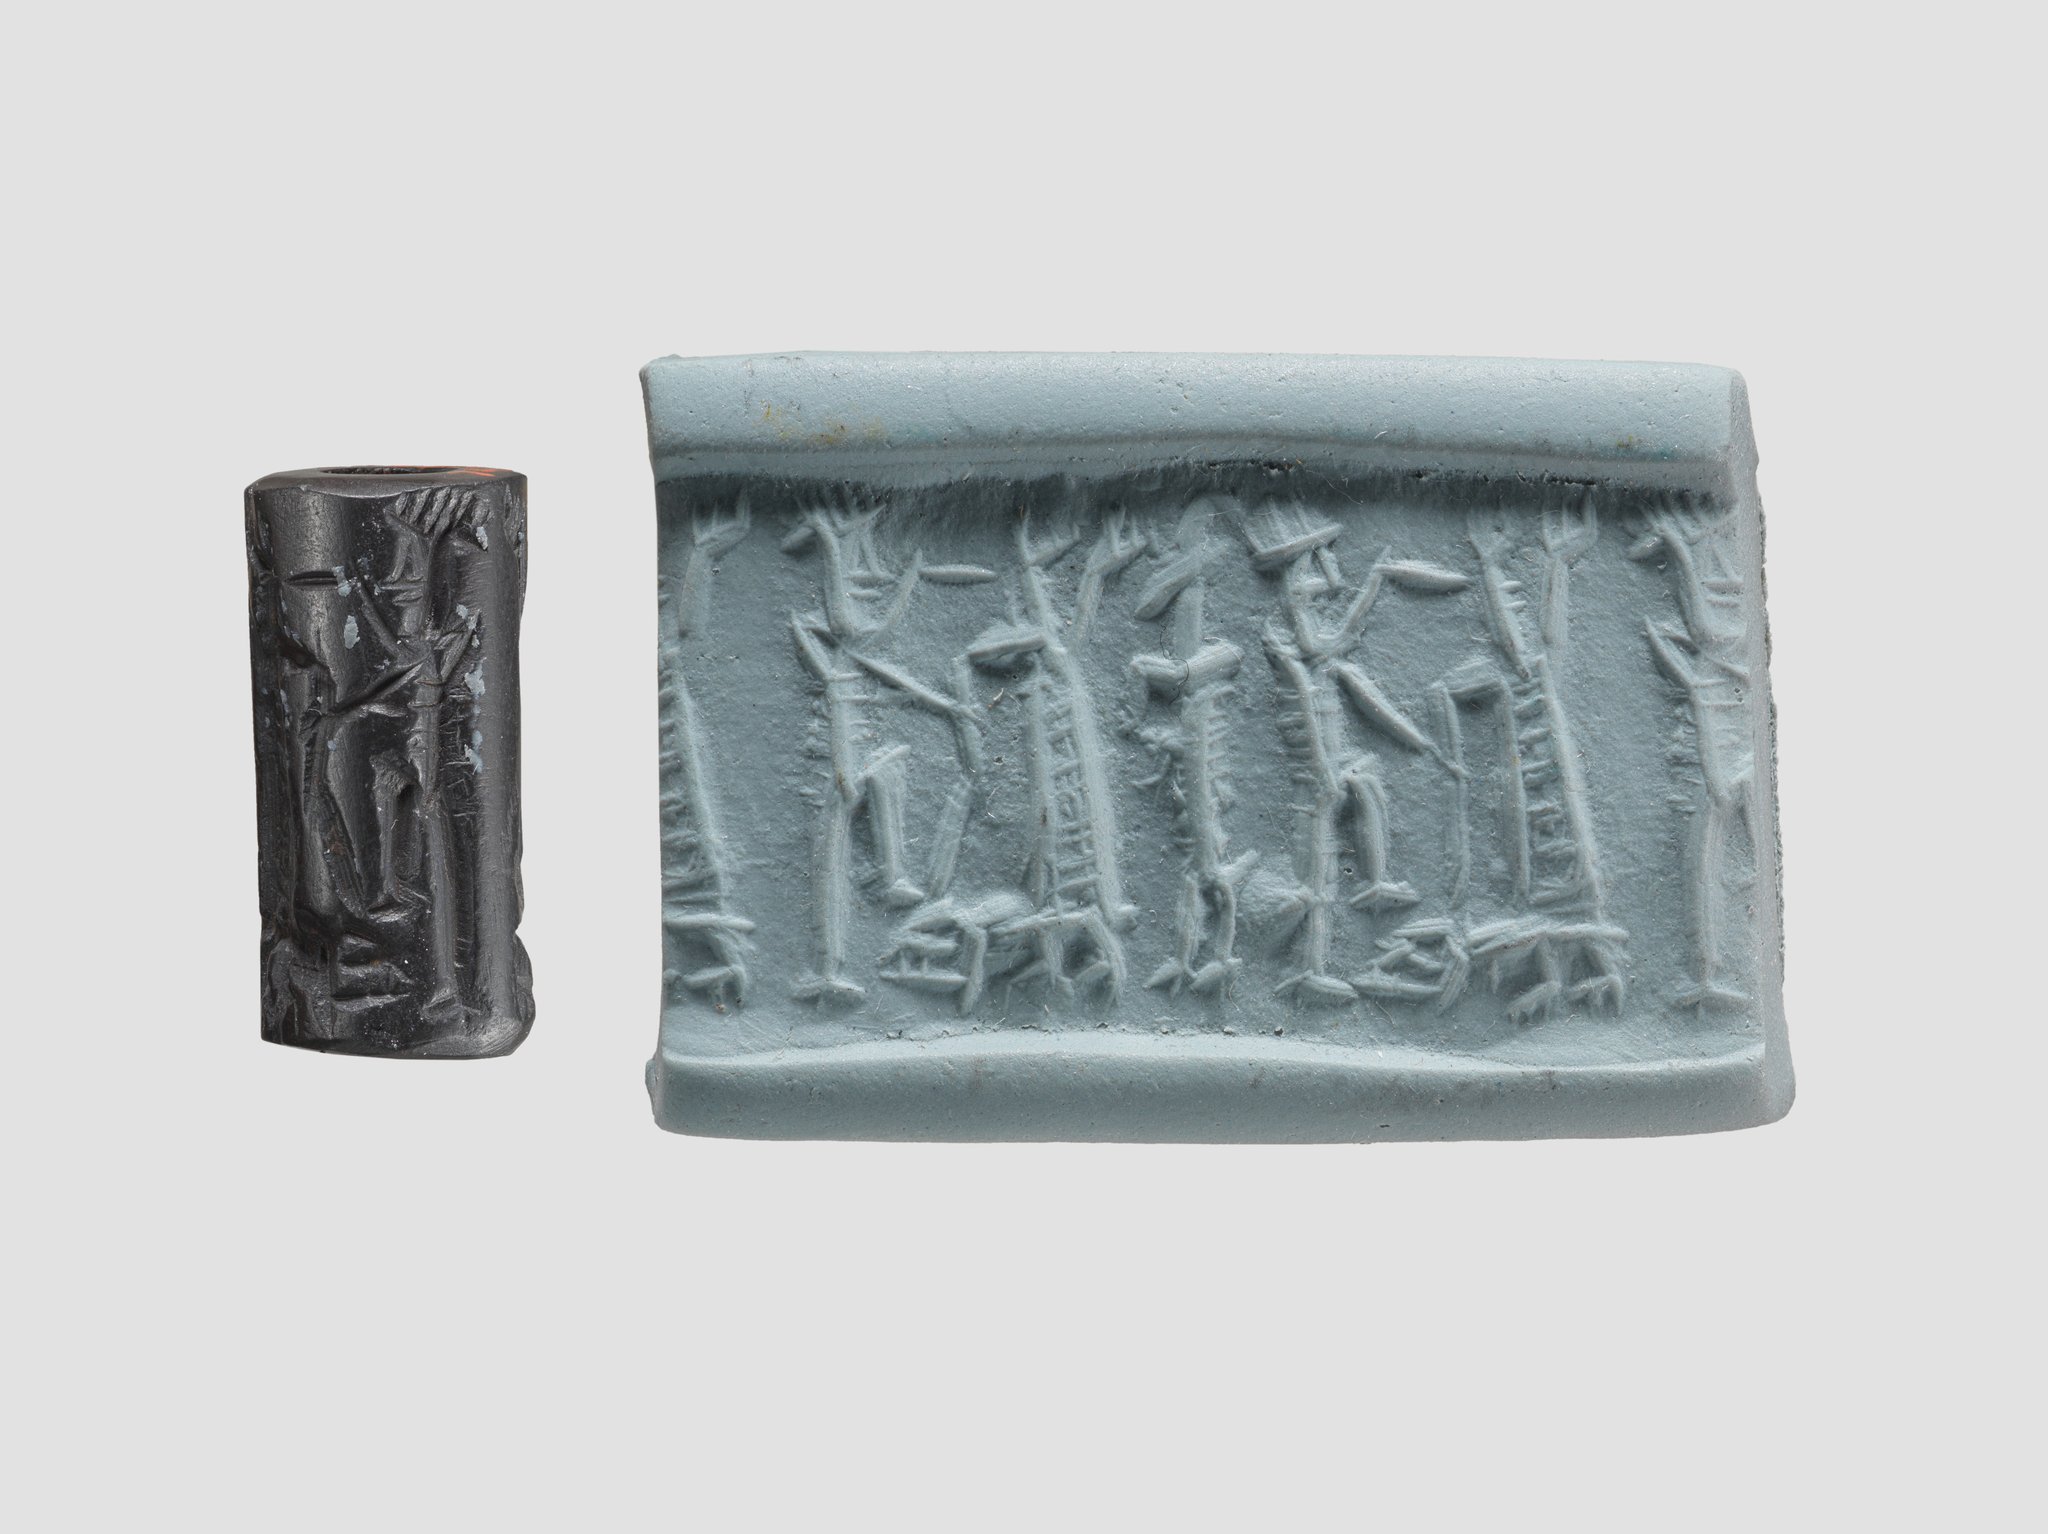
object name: cylinder seal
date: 1900-1800 BCE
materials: mineral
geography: anatolia (?)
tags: goats,lions